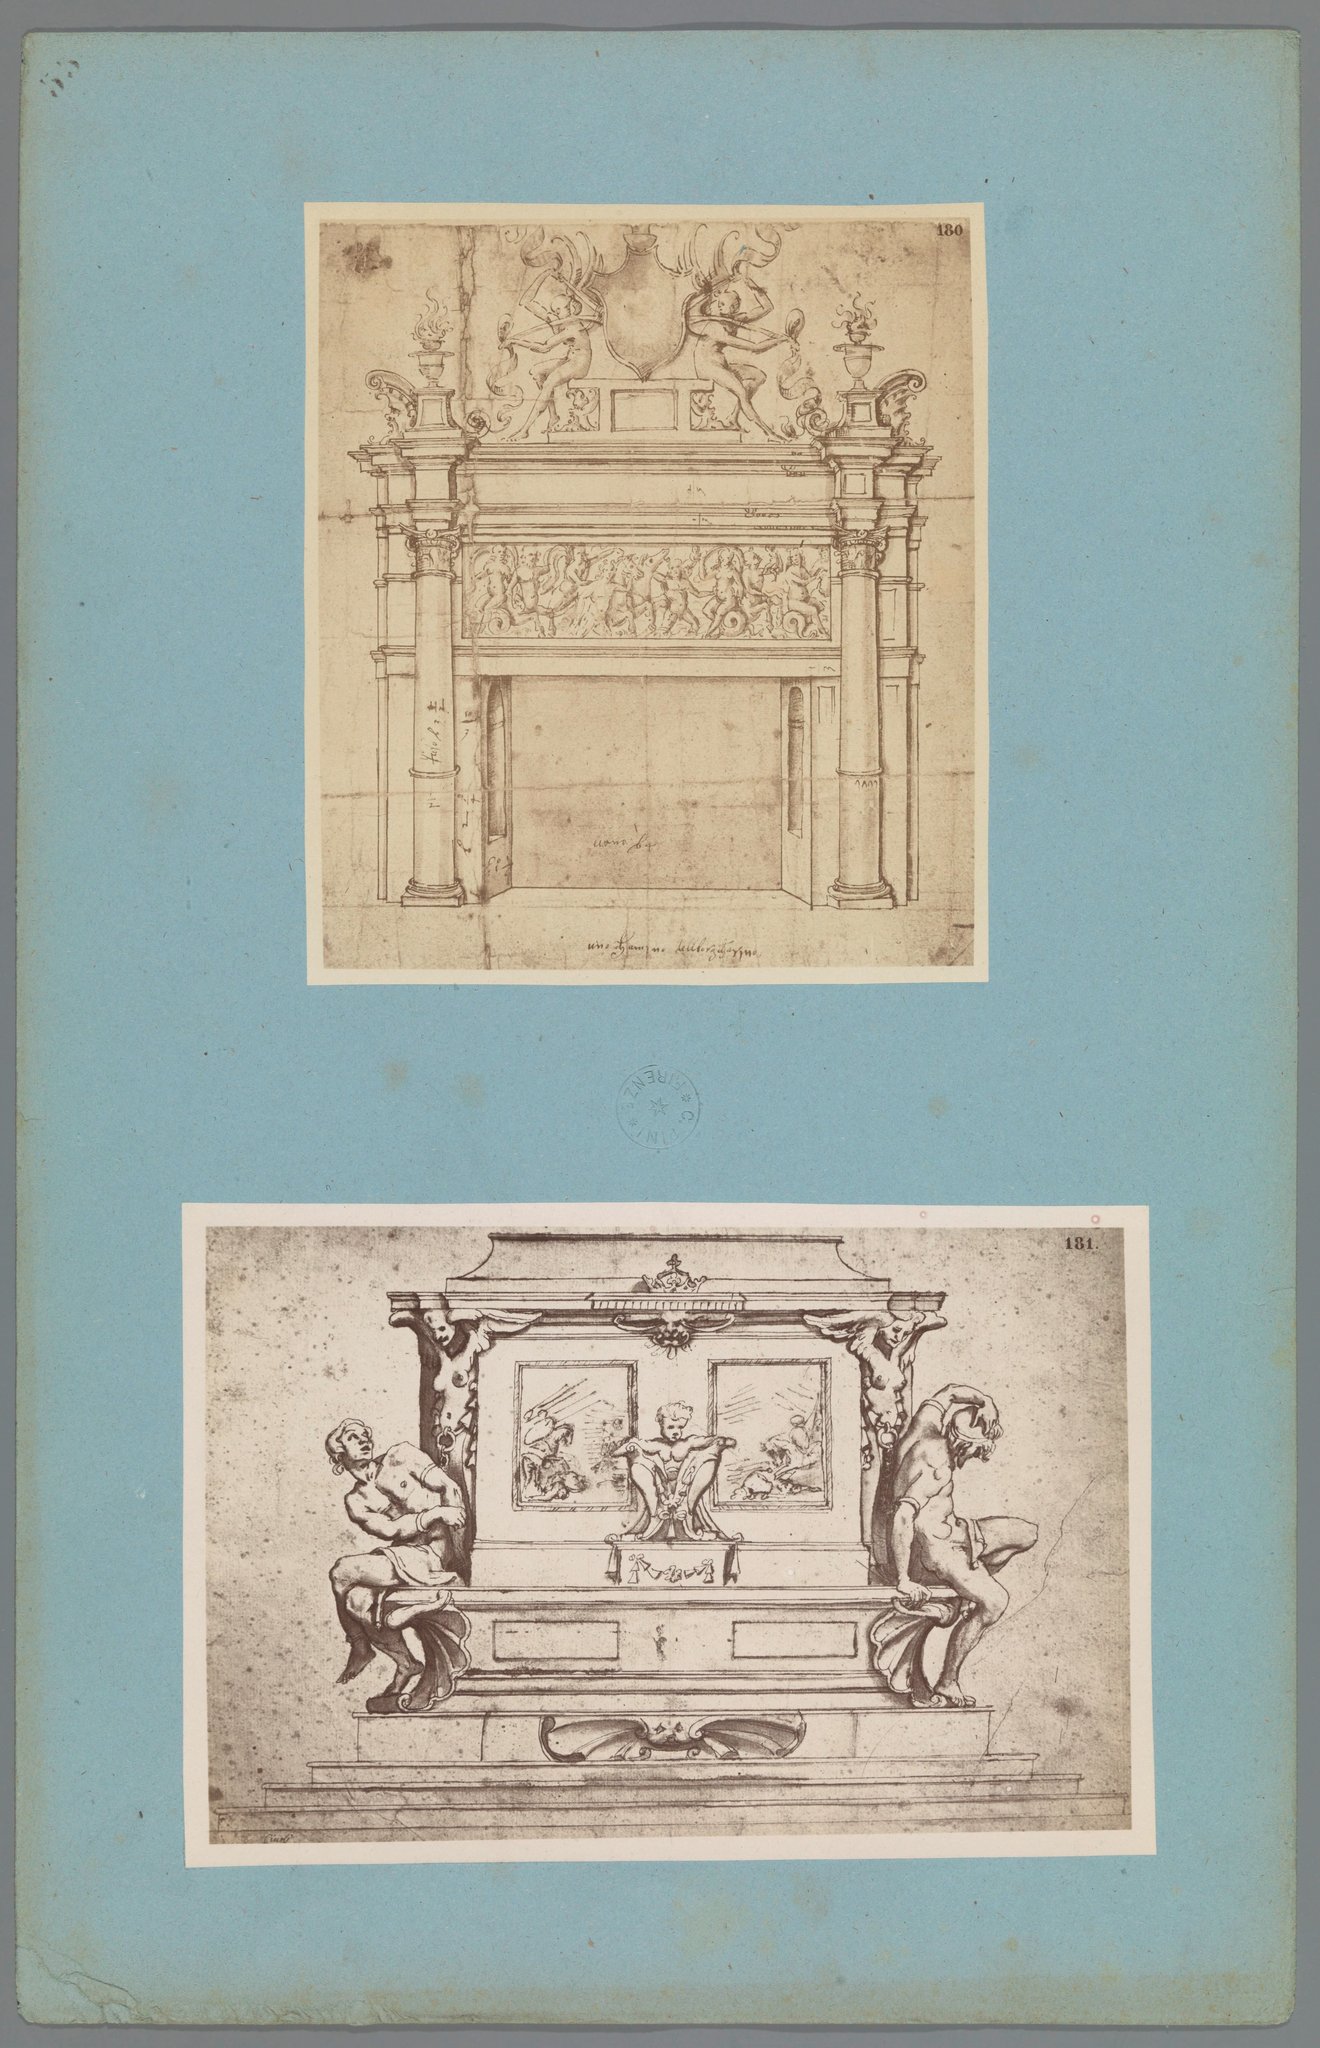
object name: reproduction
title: Twee fotoreproducties van tekeningen van een schouw en een sokkel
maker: Anonymous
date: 1875-1900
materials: cardboard, photographic support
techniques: albumen print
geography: europe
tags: open hearth, fire-place, pedestal of a piece of sculpture (perhaps in the form of a herm), other nereids (or sea-nymphs), leaning figure, europe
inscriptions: number: ‘180’, number: ‘55’, number: ‘181.’, name: ‘C. PINI FIRENZE’, collector's mark: Lugt 3937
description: Boven (180) een tekening van een schouw met Nereïden en zeewezens, onder (181) een tekening van een sokkel met leunende figuren.